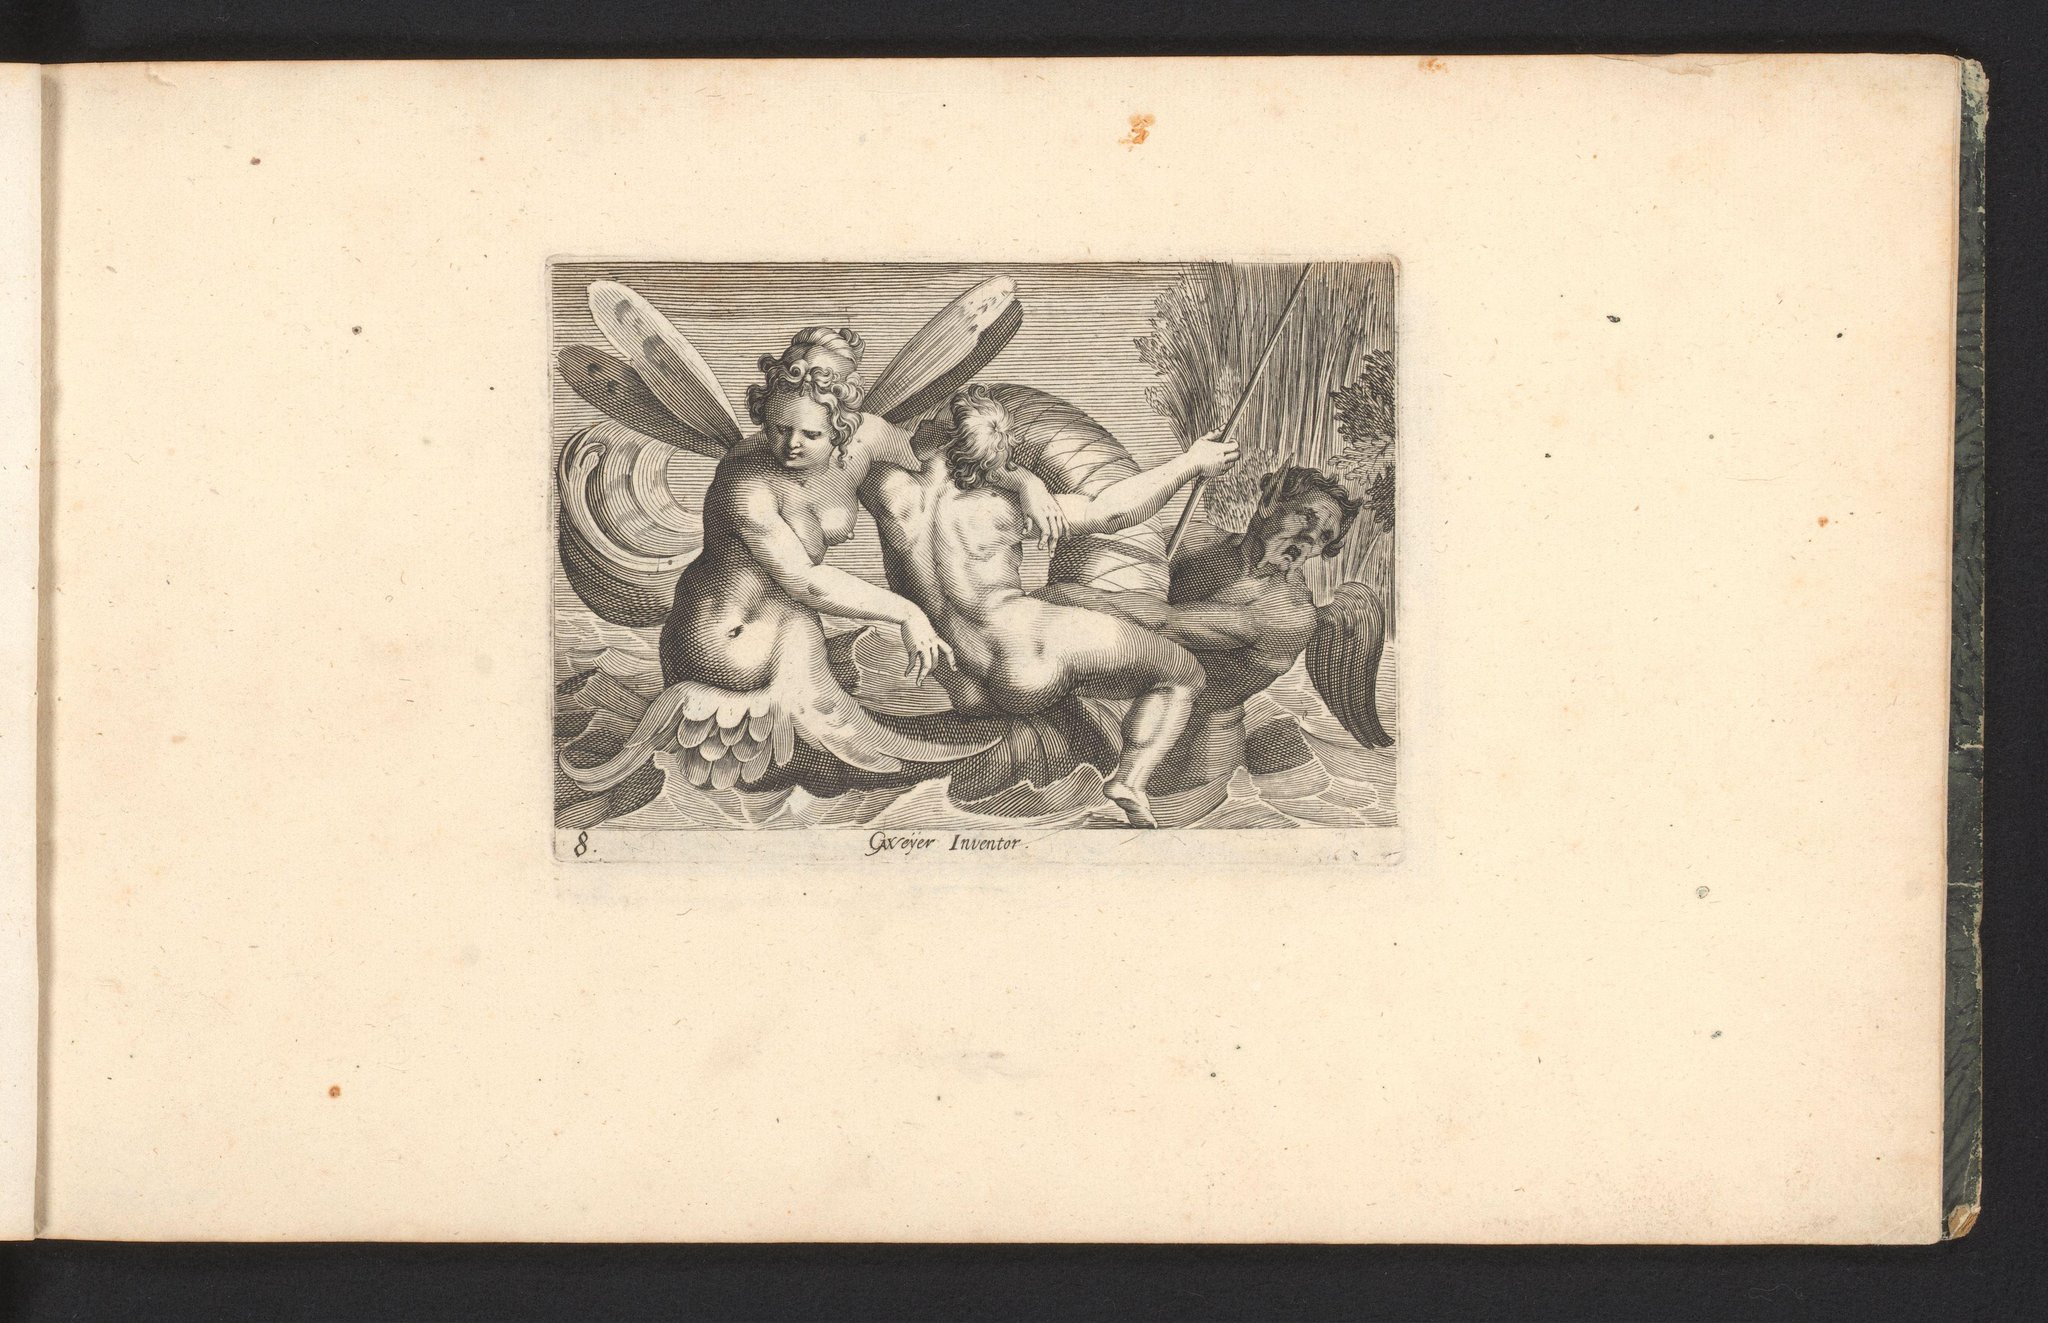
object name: album leaf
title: Zeemonsters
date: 1571-1635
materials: paper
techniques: engraving, etching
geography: nuremberg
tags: monsters of the sea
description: Een zeenimf met een vissenstaart, en een faun en een jongen, in het water.